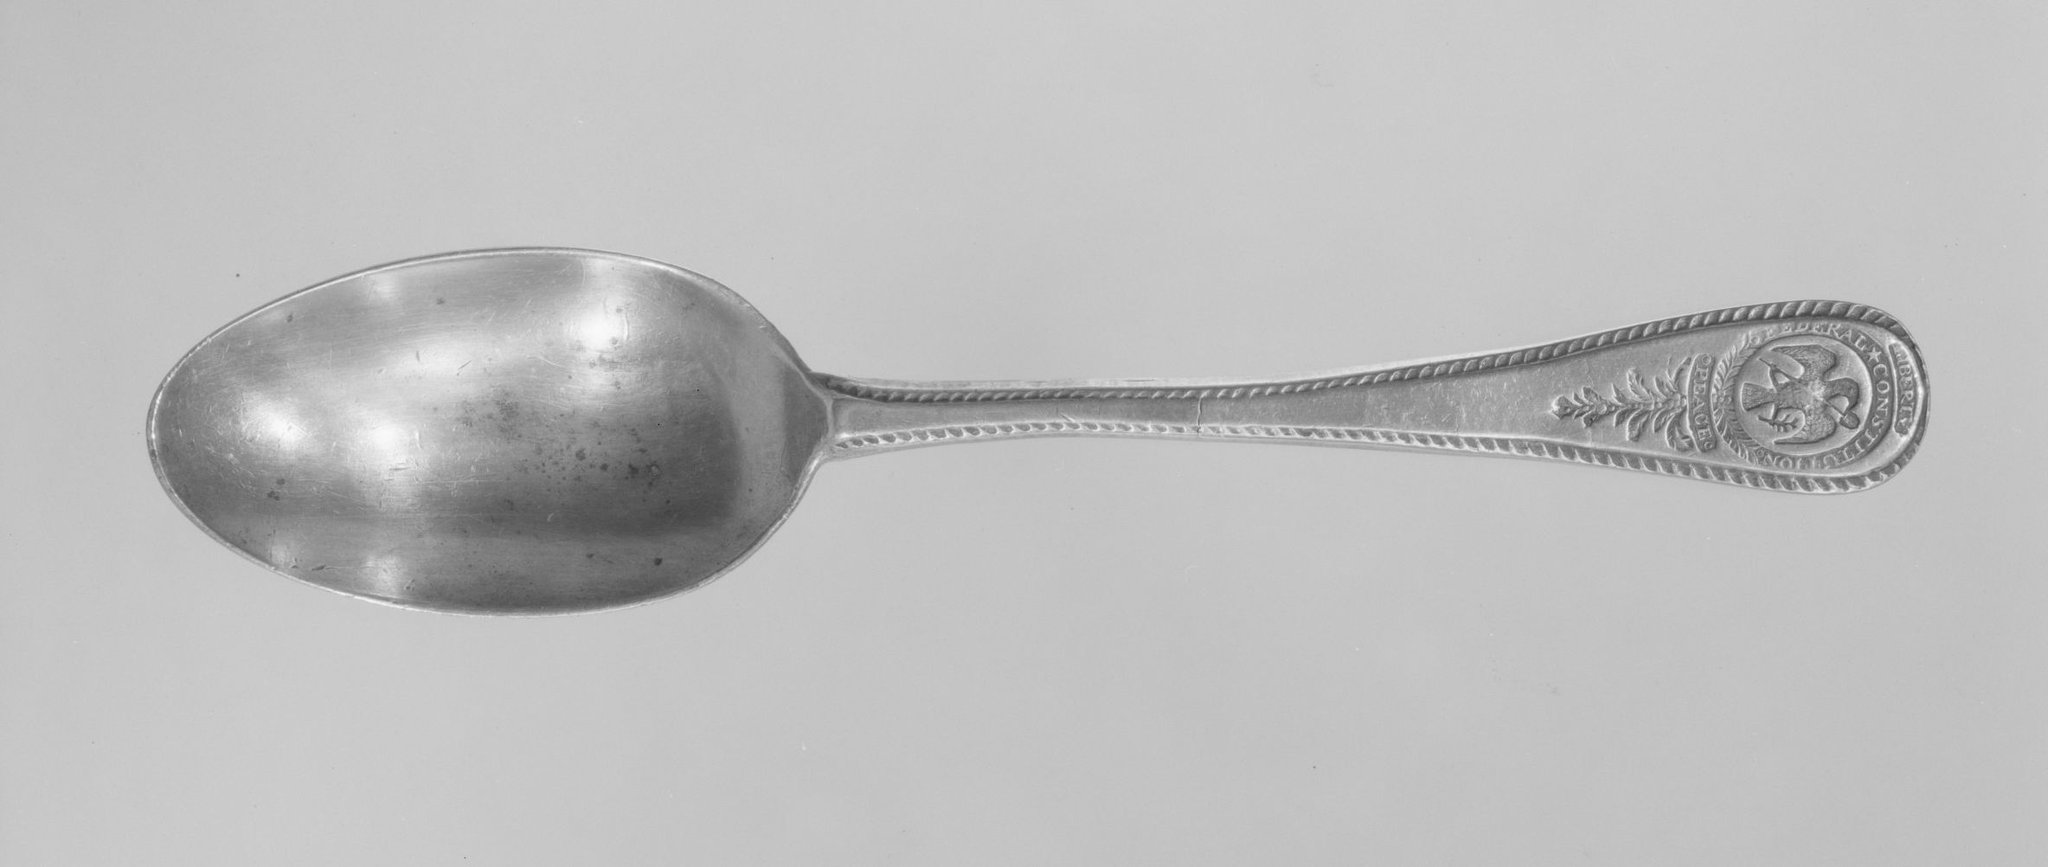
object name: spoon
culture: american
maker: george coldwell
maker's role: maker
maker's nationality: american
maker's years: 1761-1811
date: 1787-1811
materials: pewter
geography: united states